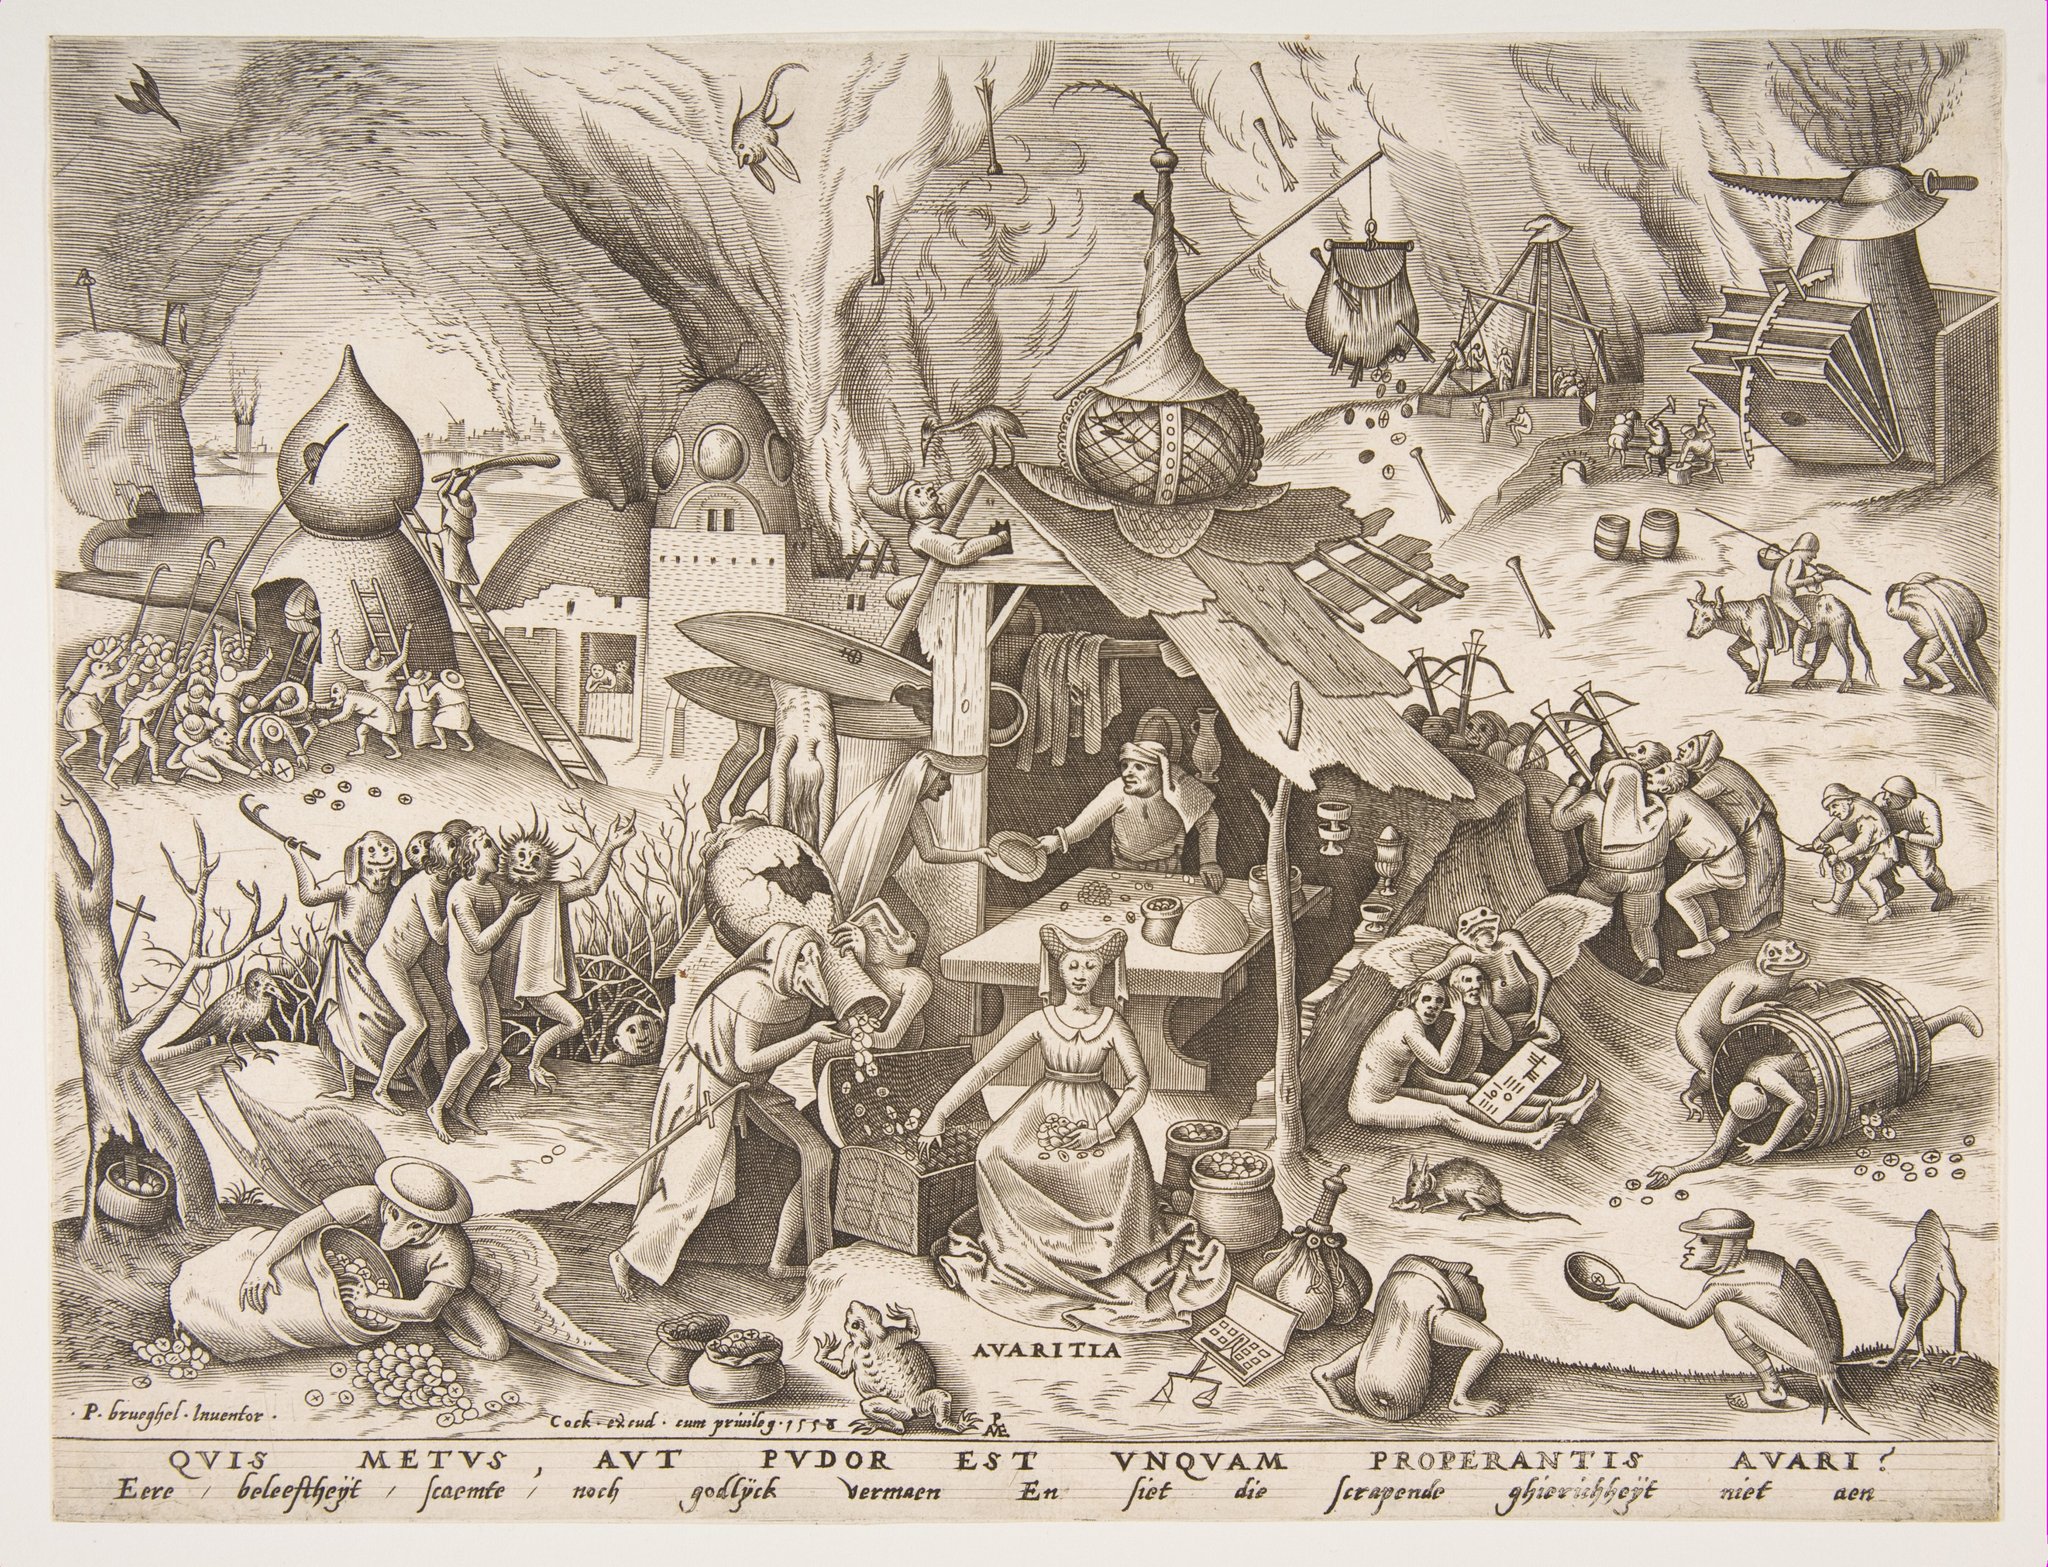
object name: print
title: Avarice (Avaritia), from "The Seven Deadly Sins"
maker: pieter van der heyden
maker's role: artist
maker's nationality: netherlandish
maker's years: 1525-1569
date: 1558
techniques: engraving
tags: men,women,frogs,coins